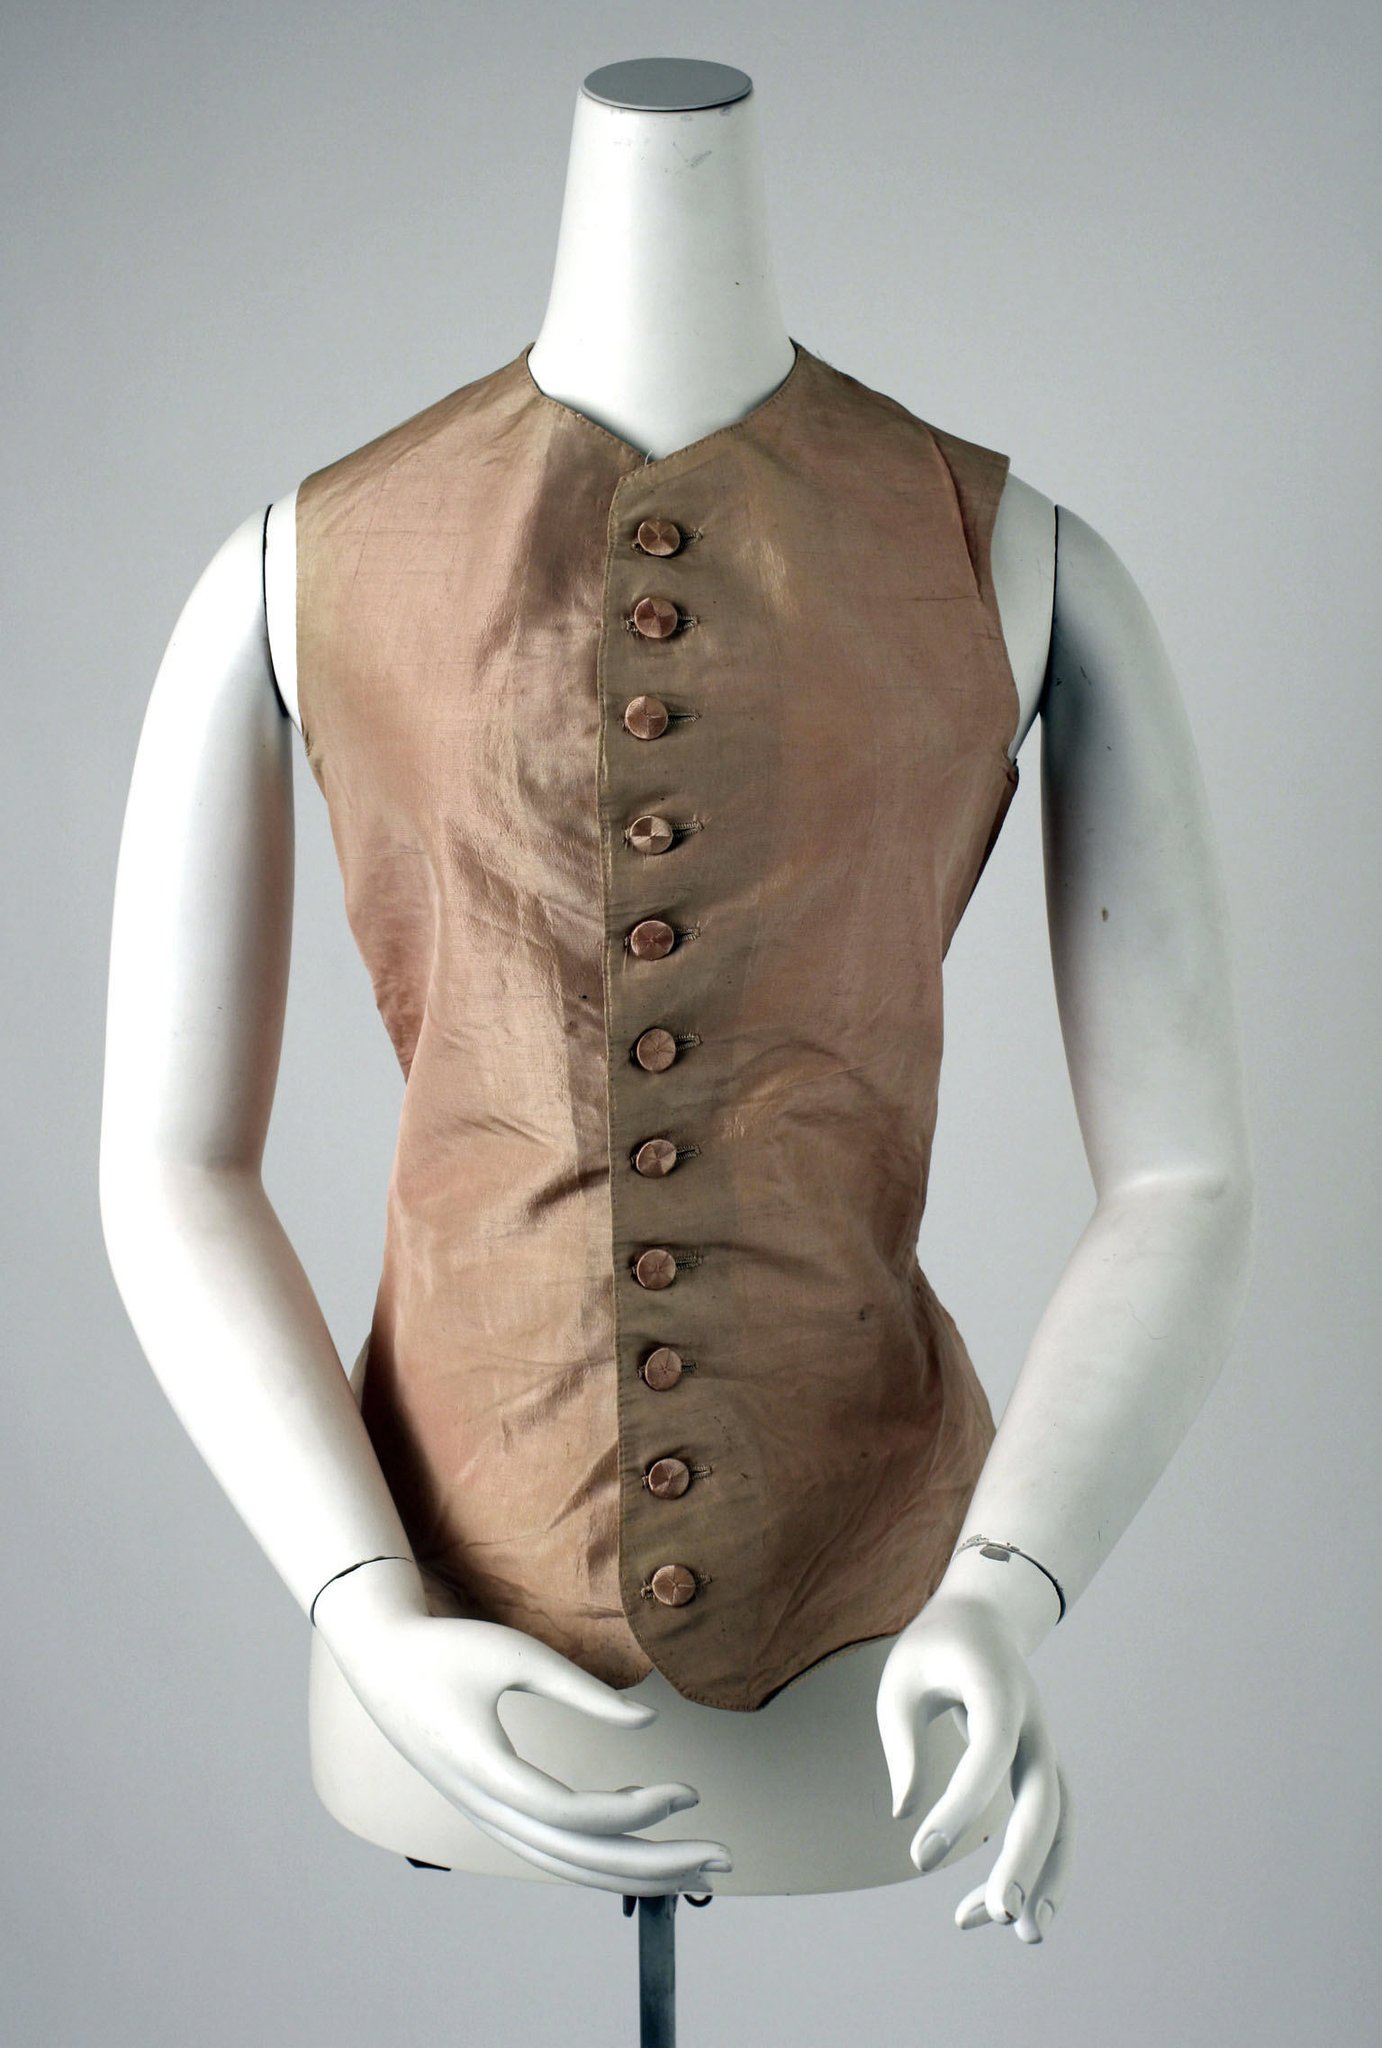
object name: riding waistcoat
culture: british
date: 1775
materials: linen, silk